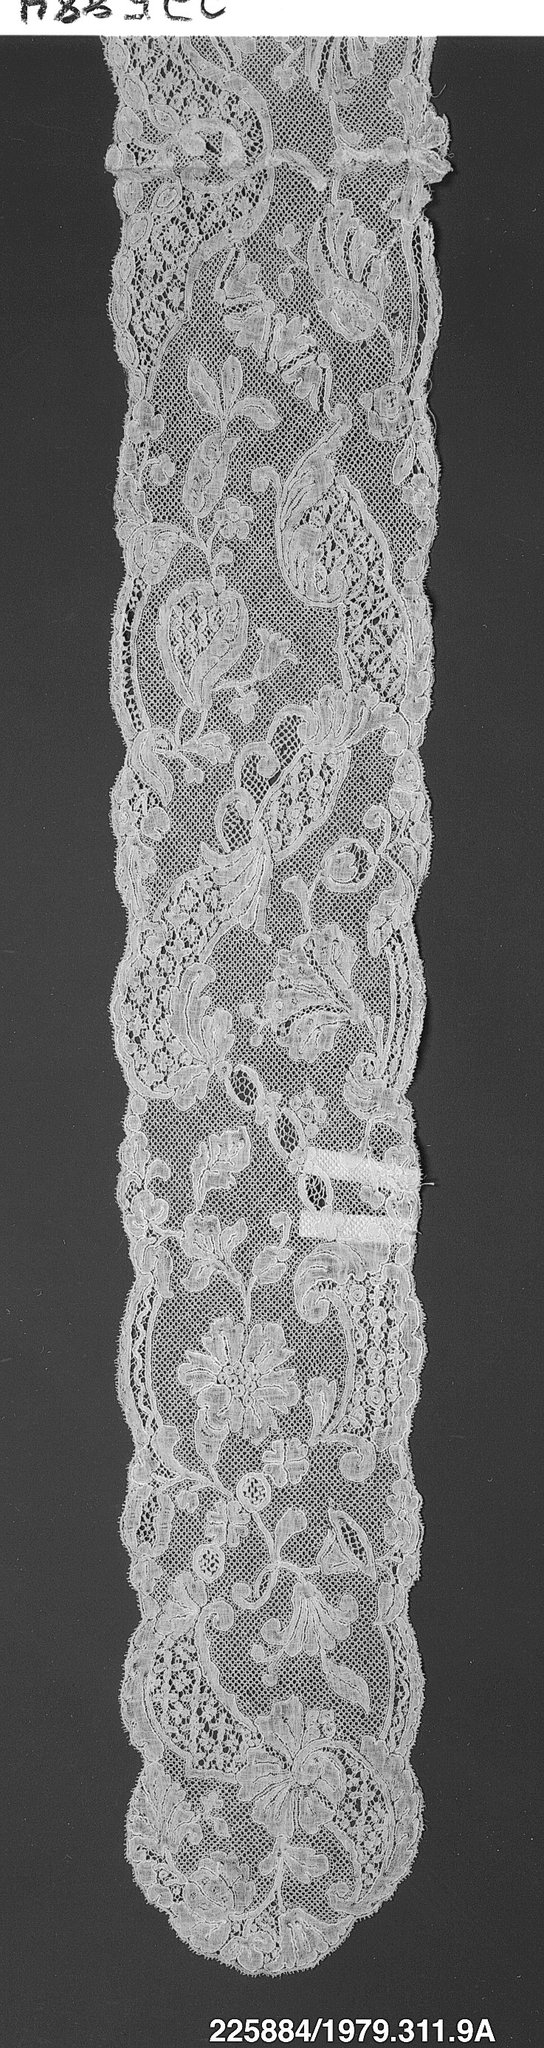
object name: lappet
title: Two joined lappets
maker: mechlin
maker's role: manufactory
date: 1734-1766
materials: linen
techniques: lace